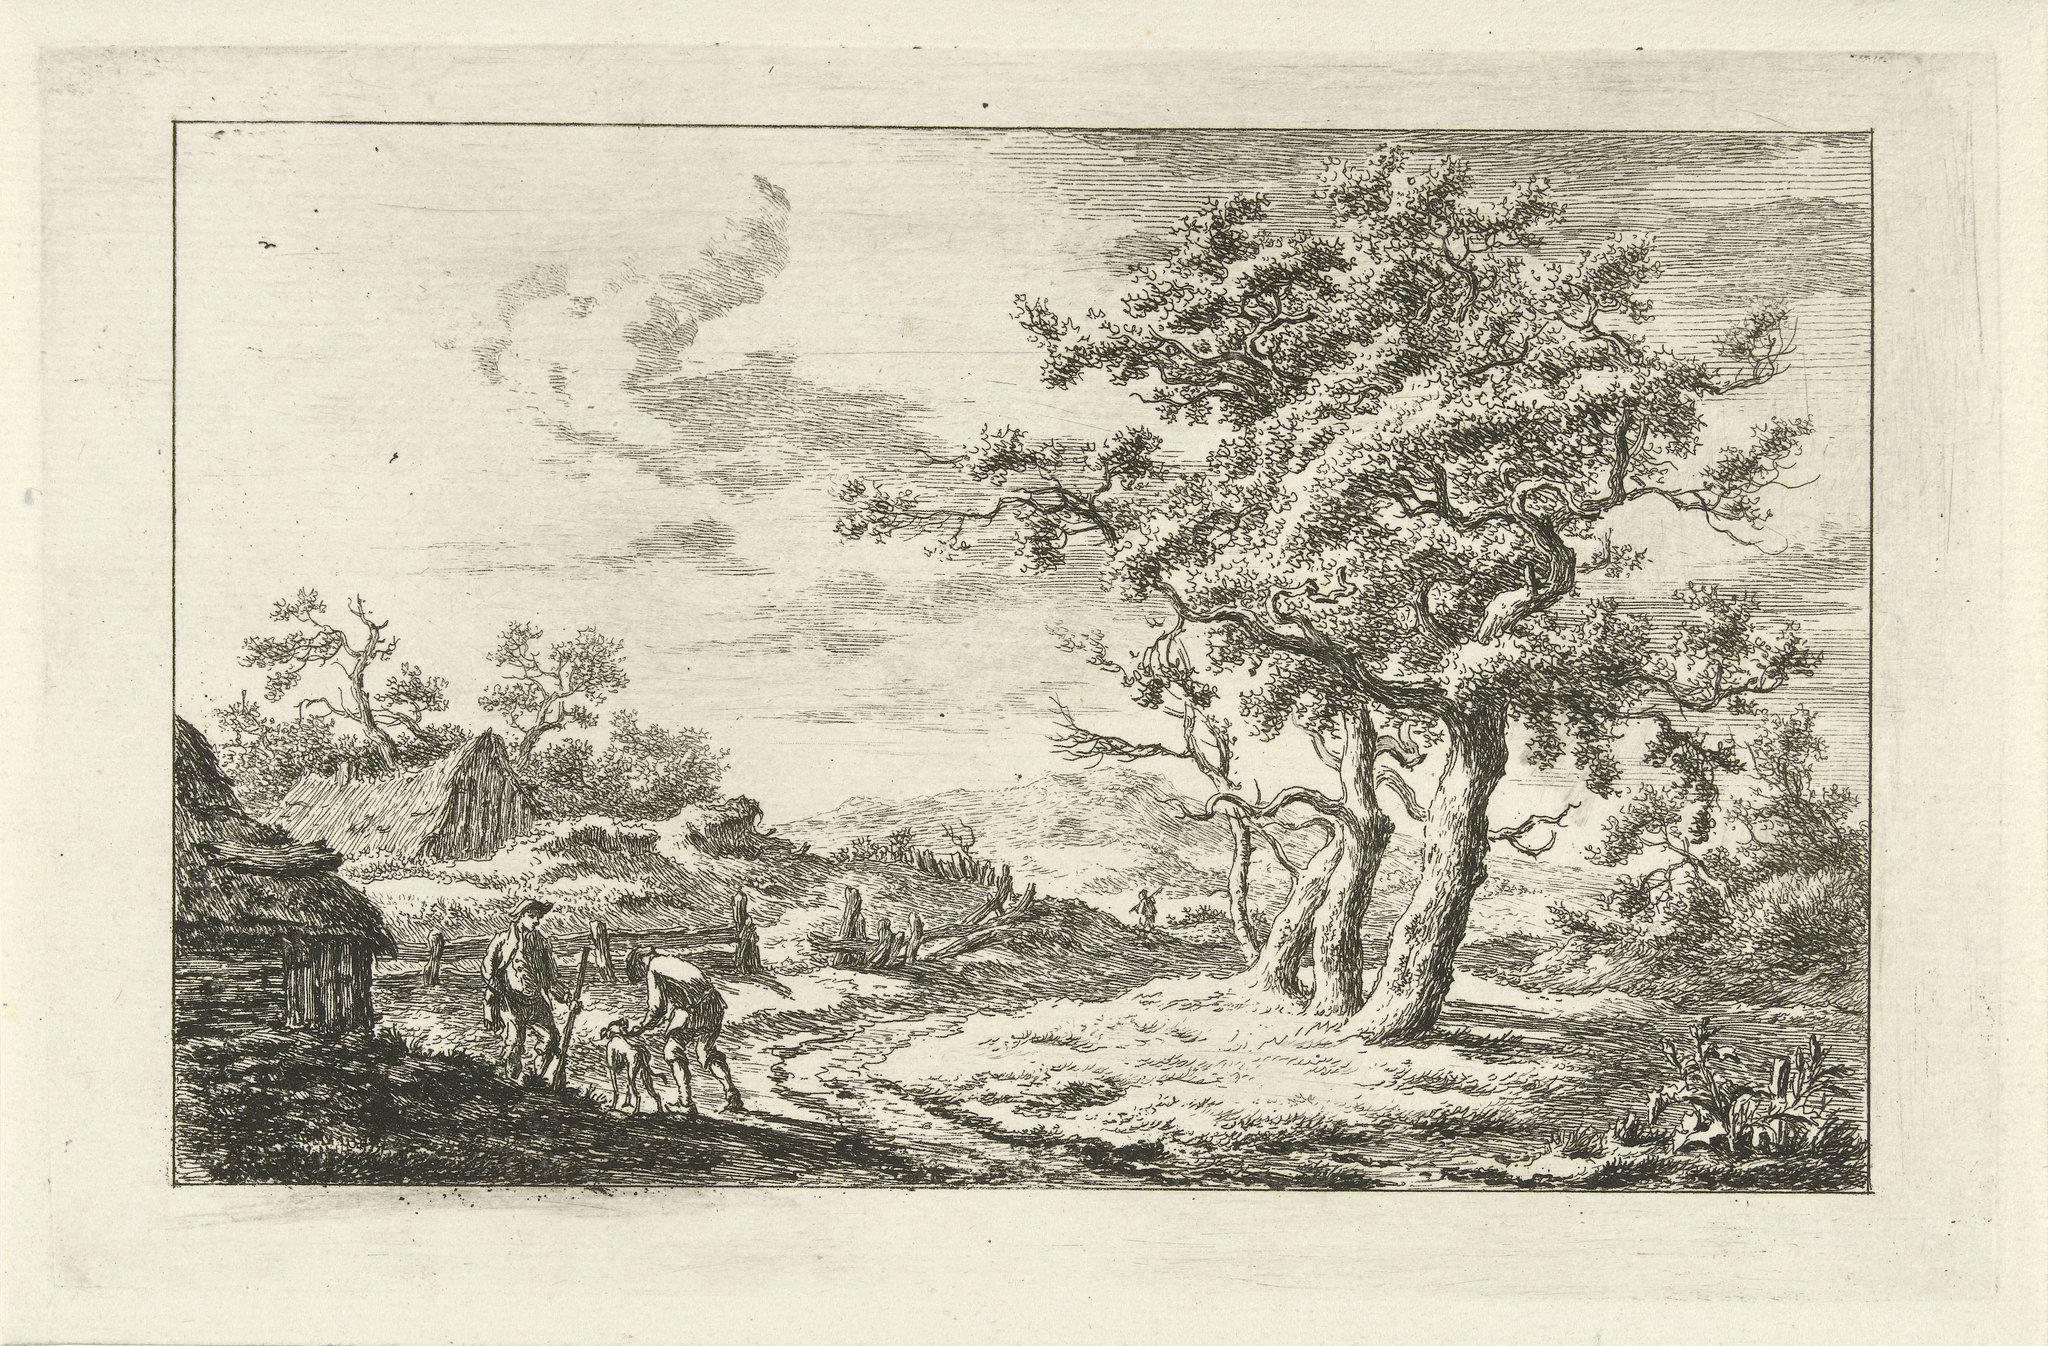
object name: print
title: Landschappen (a-f)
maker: carel lodewijk hansen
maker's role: draughtsman, painter, print maker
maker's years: 1765-1840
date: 1780-1840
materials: paper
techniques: etching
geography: netherlands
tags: hunter, landscapes (+ landscape with figures, staffage), dog, haarlem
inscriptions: collector's mark: Lugt 2228